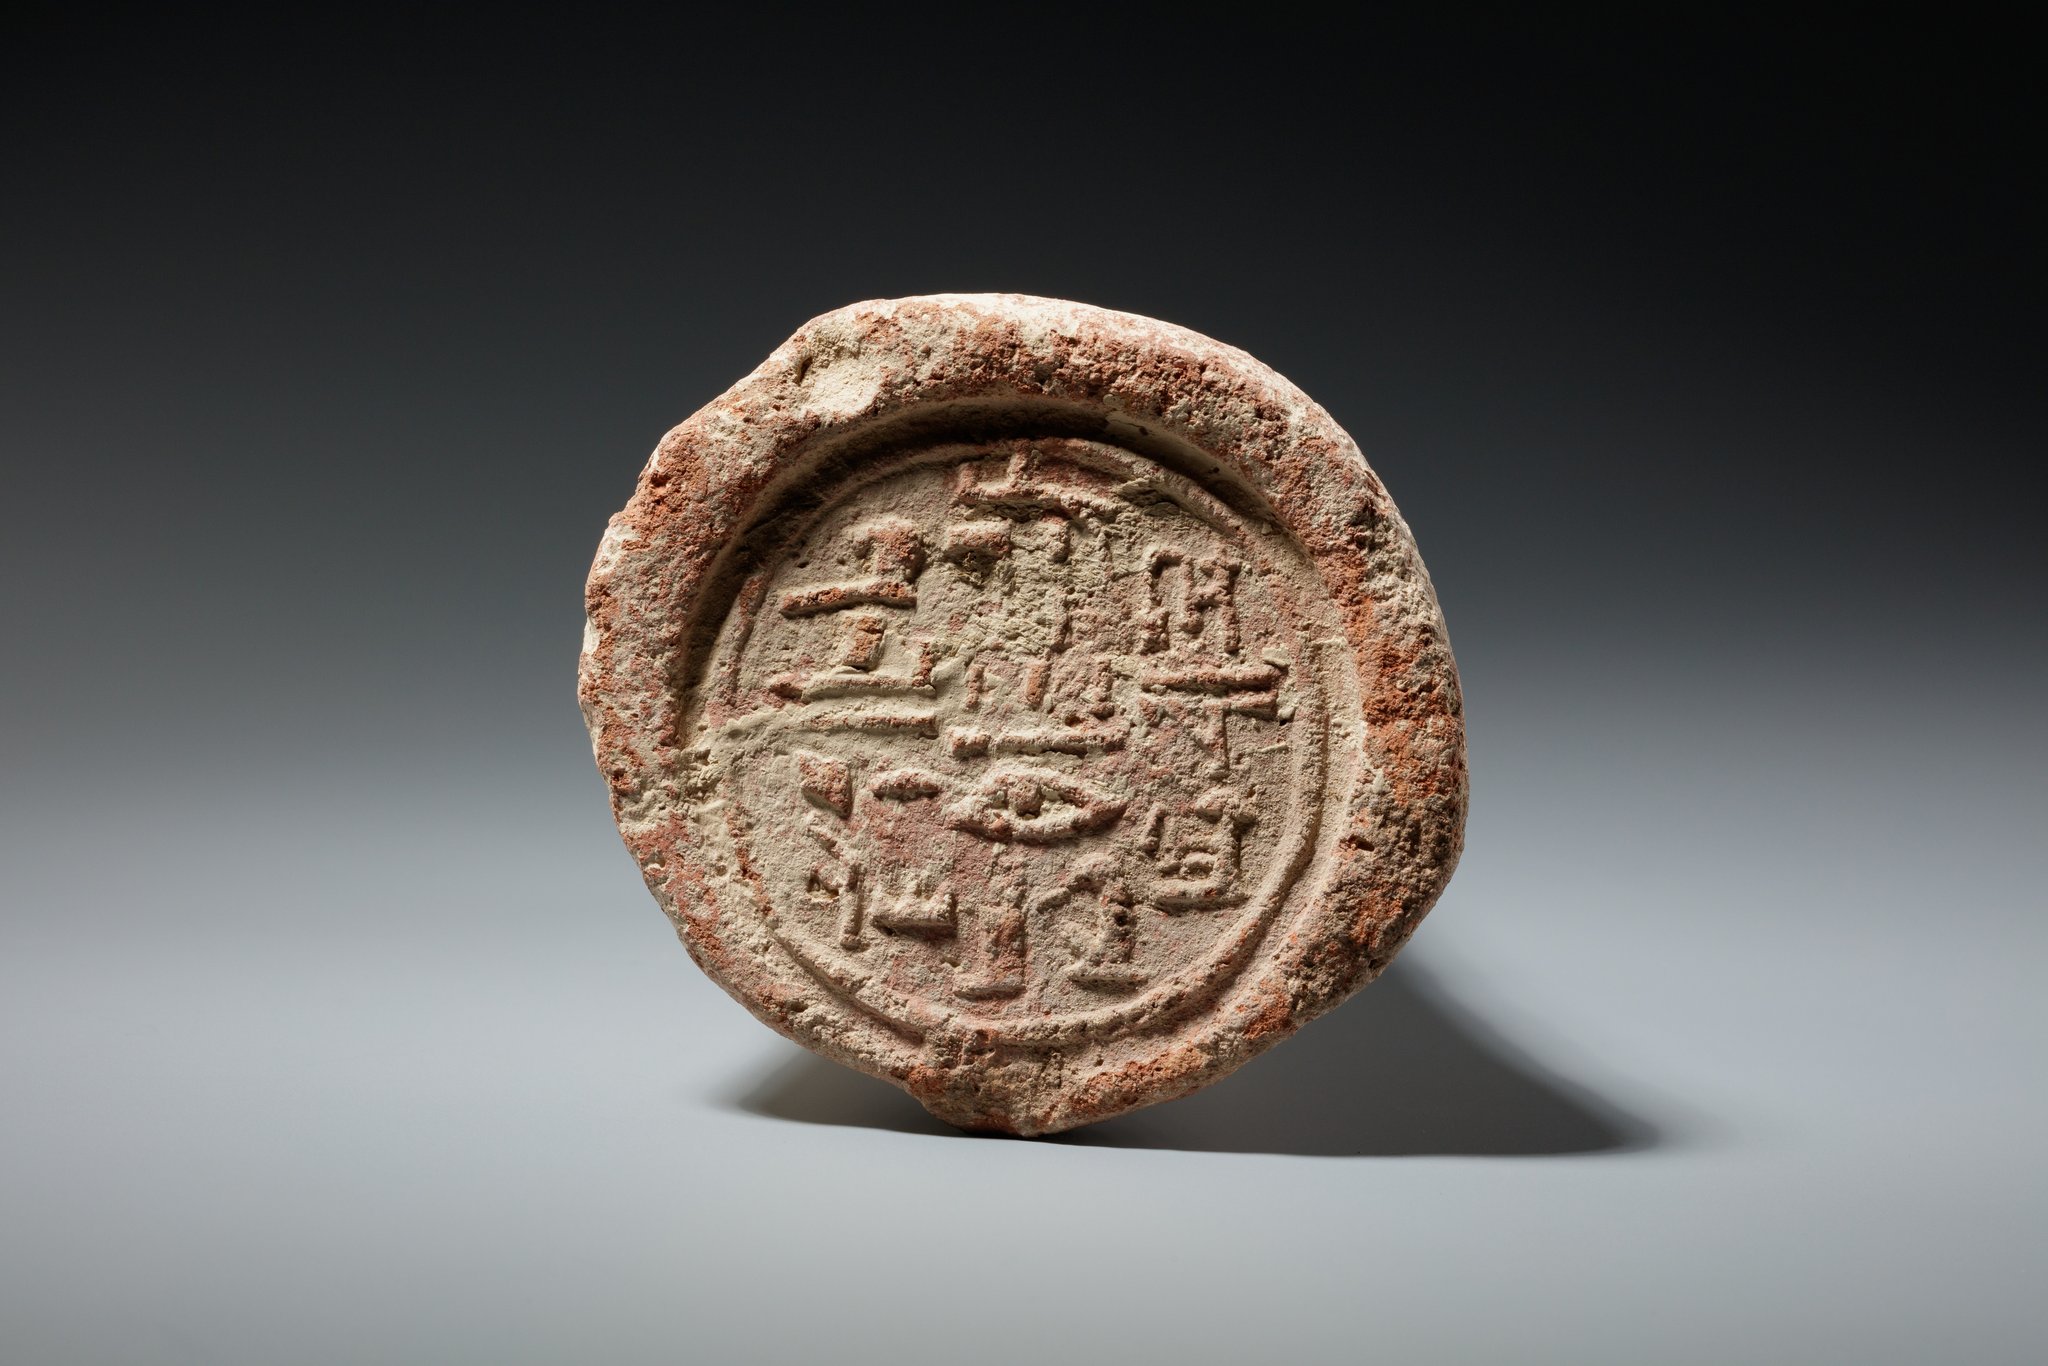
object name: cone, davy 222, min, tt 109, scribe, overseer, priest, osiris, oasis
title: Funerary Cone of the Scribe Min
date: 1479-1425 BCE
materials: pottery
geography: egypt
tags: hieroglyphs